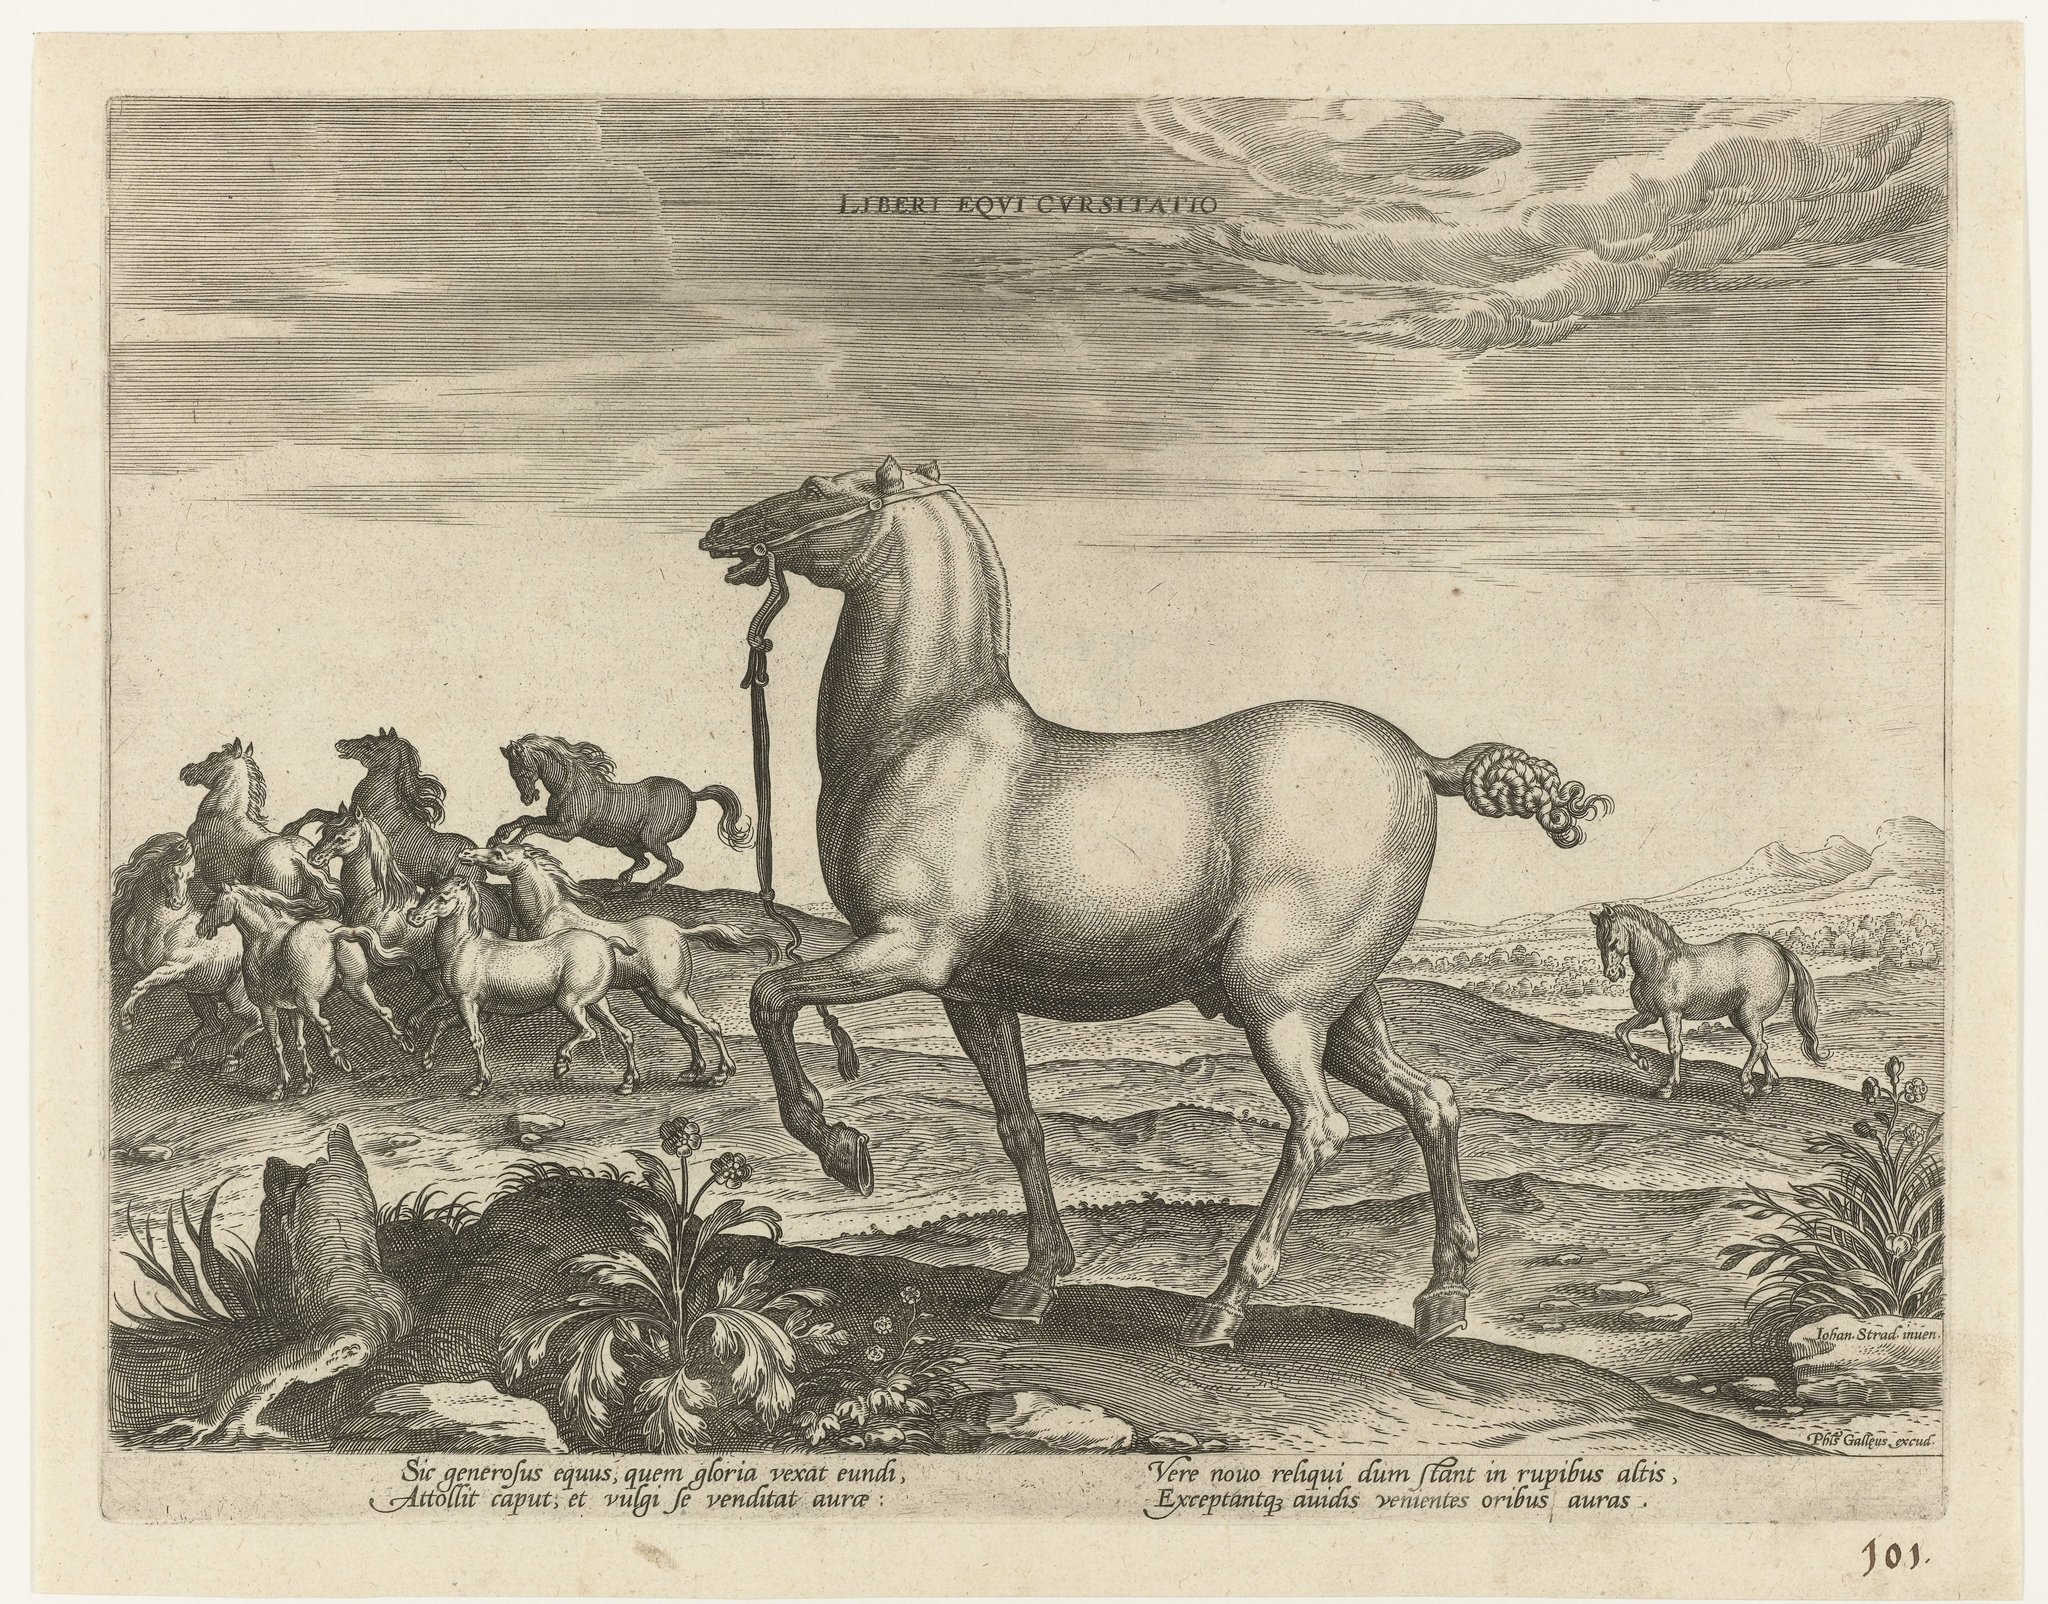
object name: print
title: Paardenrassen uit de Koninklijke stallen van Don Juan van Oostenrijk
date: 1578-1582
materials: paper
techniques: engraving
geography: florence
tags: don juan van oostenrijk, horses and kindred animals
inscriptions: collector's mark: Lugt 2228, number: ‘101’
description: In de voorgrond een paard in profiel. In de achtergrond een kudde wilde paarden. De prent heeft een Latijns onderschrift en maakt deel uit van het vierde deel van een 39-delige serie over de paardenrassen uit Koninklijke stallen van Don Juan van Oostenrijk.